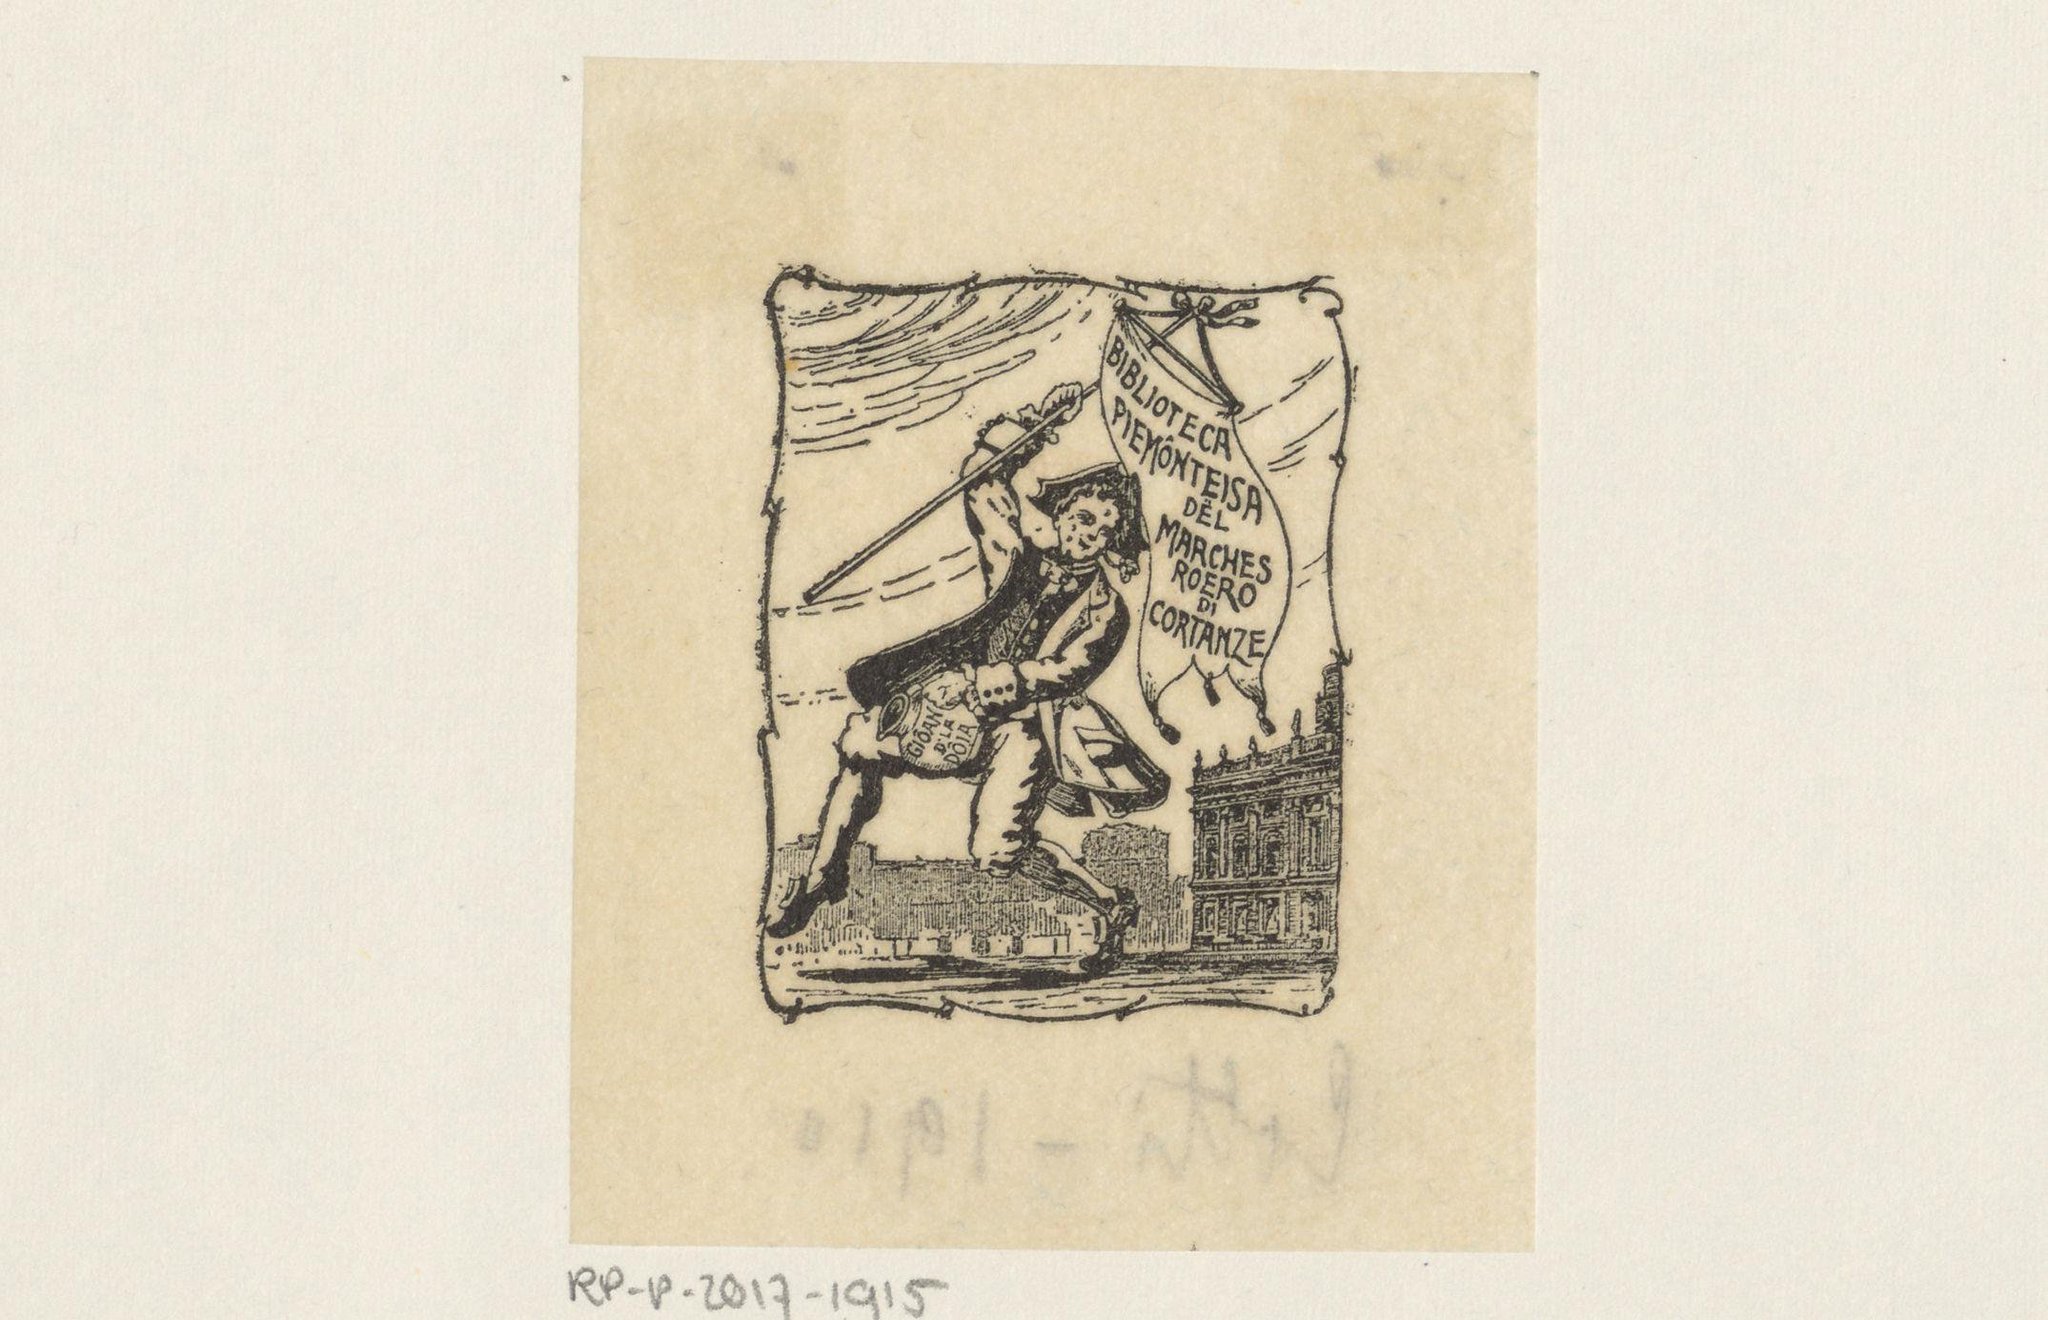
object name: bookplate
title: Ex libris van de Biblioteca Piemonteisa del marches Roero di Cortanze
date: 1910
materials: paper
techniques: printing block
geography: italy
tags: historical costume, banner, standard (as symbol of the state, etc.), man dancing alone, village square, place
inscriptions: inscription: ‘Lotti 1910’